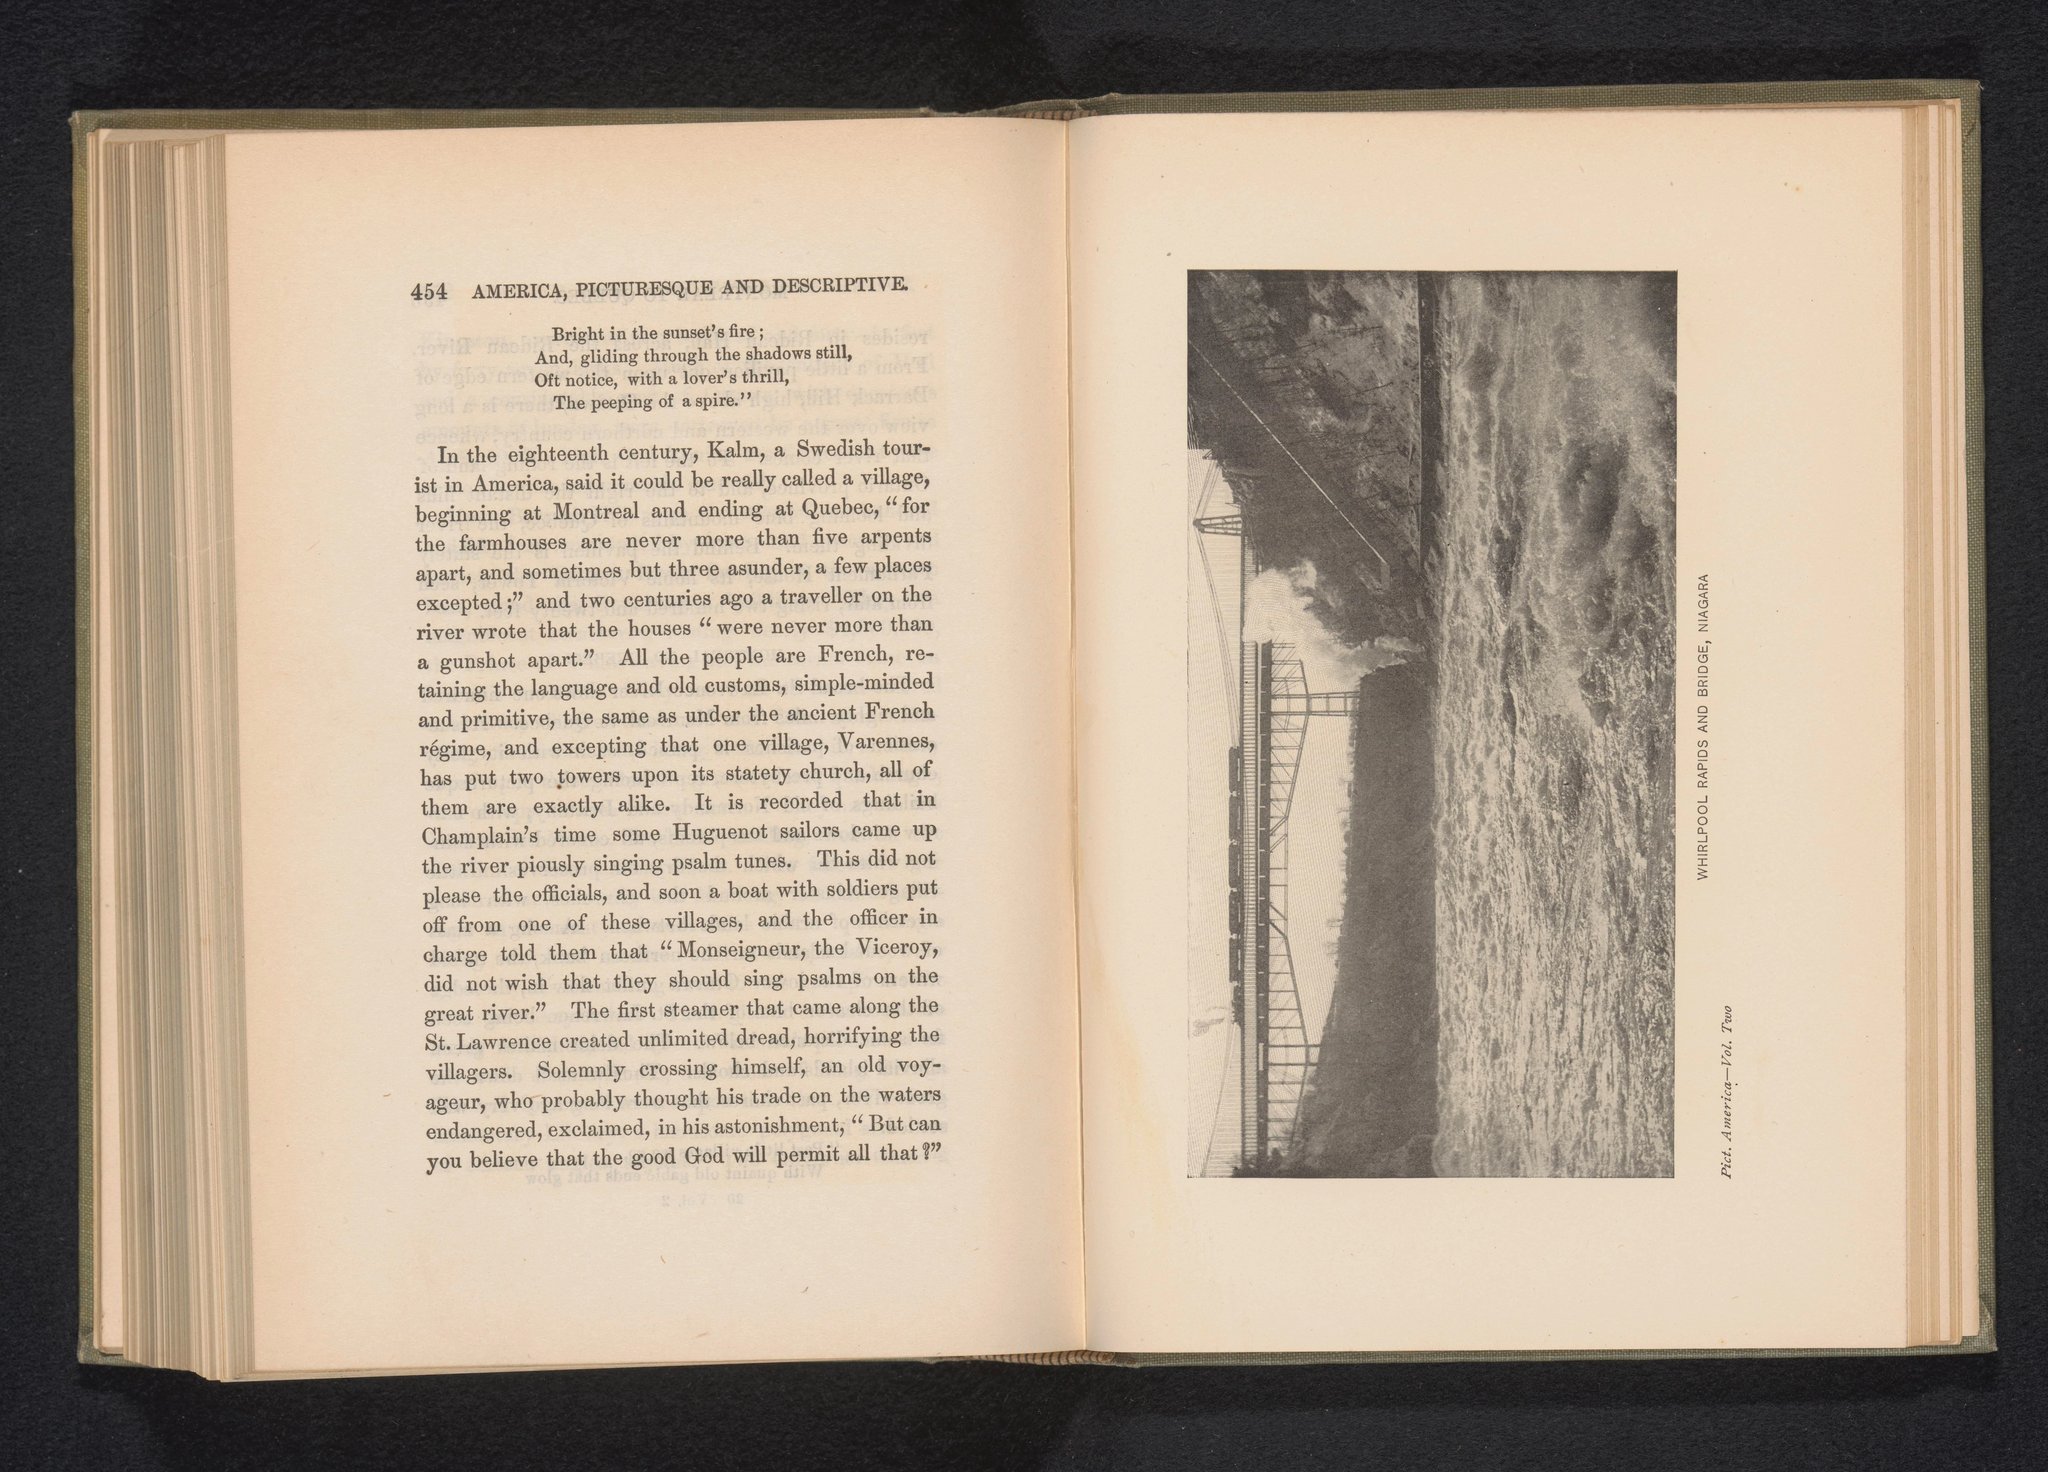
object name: page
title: Whirlpool rapids and bridge, Niagara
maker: Anonymous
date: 1890-1900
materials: paper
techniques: autotype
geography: niagara falls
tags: rapids, river, suspension bridge